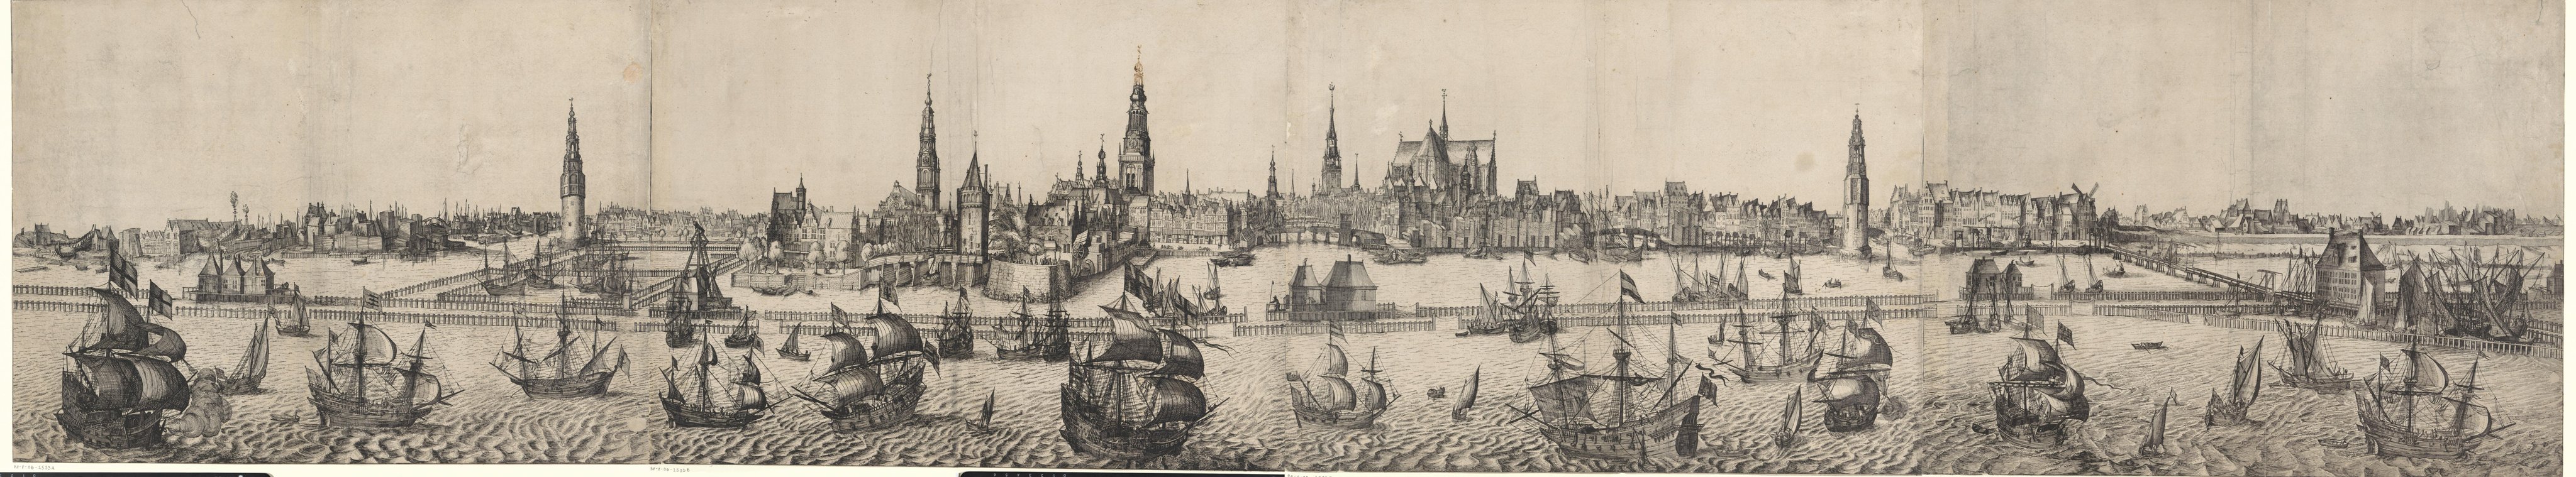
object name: print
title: Gezicht op Amsterdam, vanaf het IJ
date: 1612-1652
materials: paper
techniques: etching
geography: amsterdam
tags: head-gear, farmers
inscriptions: collector's mark: Lugt 2228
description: Gezicht op Amsterdam, gezien vanaf het IJ. Op het IJ varen verschillende schepen en bootjes. Links de Montelbaanstoren, de ZuiderKerk, de Schreierstoren en de Oude Kerk en in het midden het Oude stadhuis op de Dam, de Nieuwe kerk en de Haringpakkerstoren en rechts de Haarlemmerdijk.